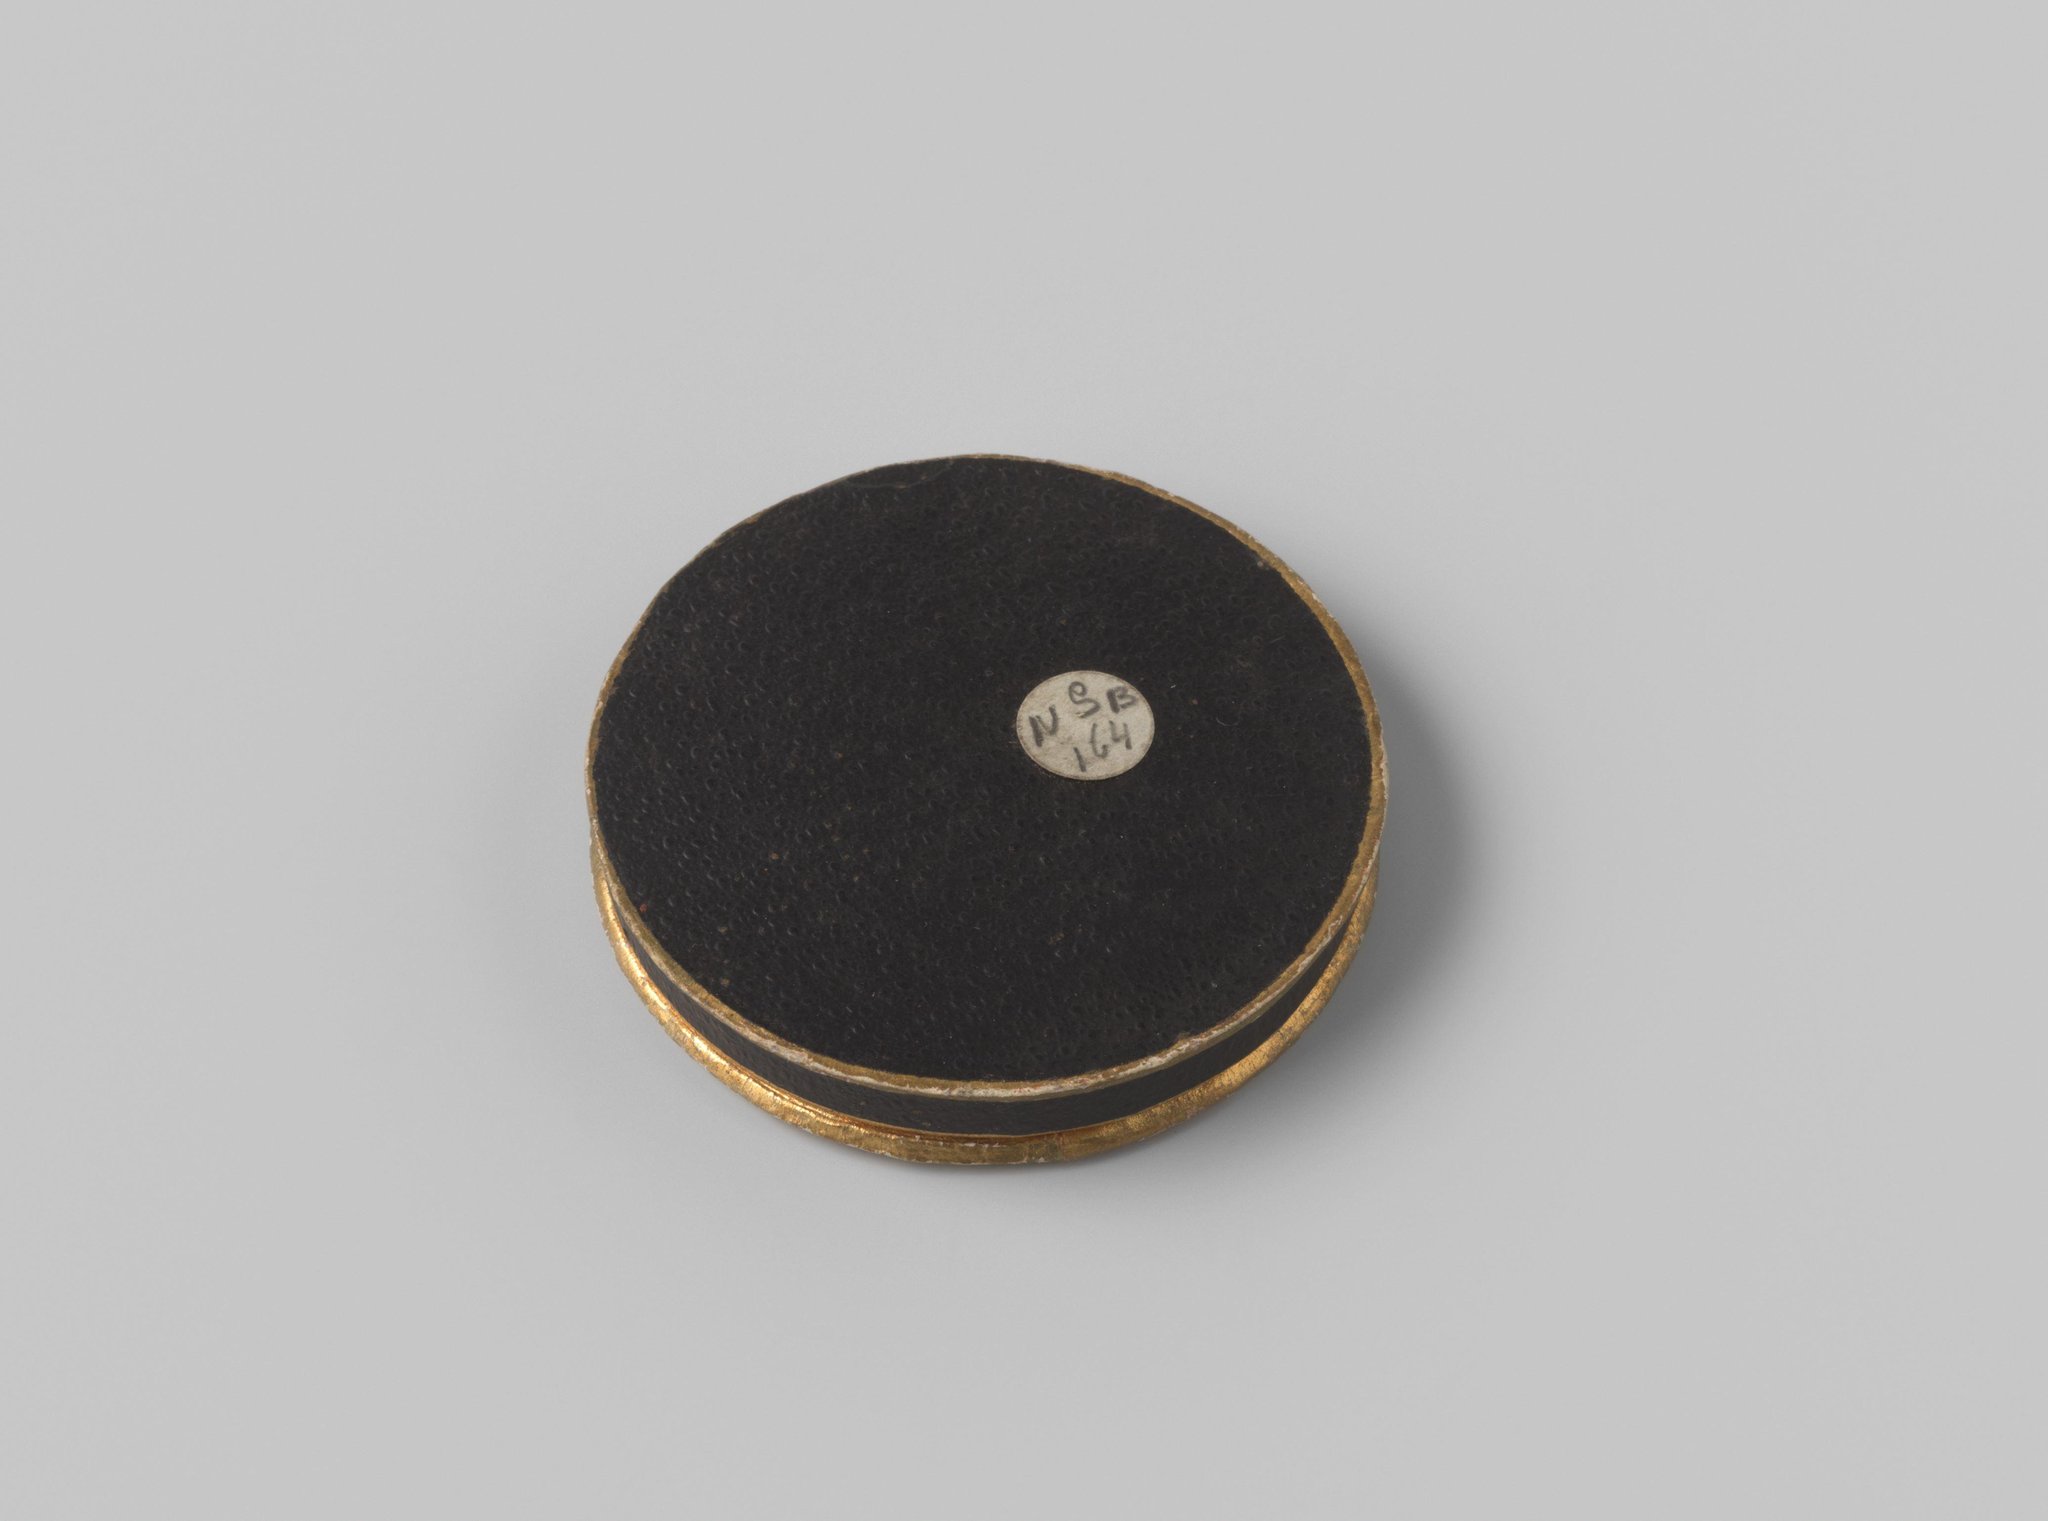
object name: box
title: Doos horend bij een bronzen penning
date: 1887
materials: cardboard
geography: utrecht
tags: rome, leo xiii, netherlands, italy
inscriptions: date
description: Rond kartonnen doosje met goudkleurige rand. De binnenkant is bekleedt met paars fluweel.